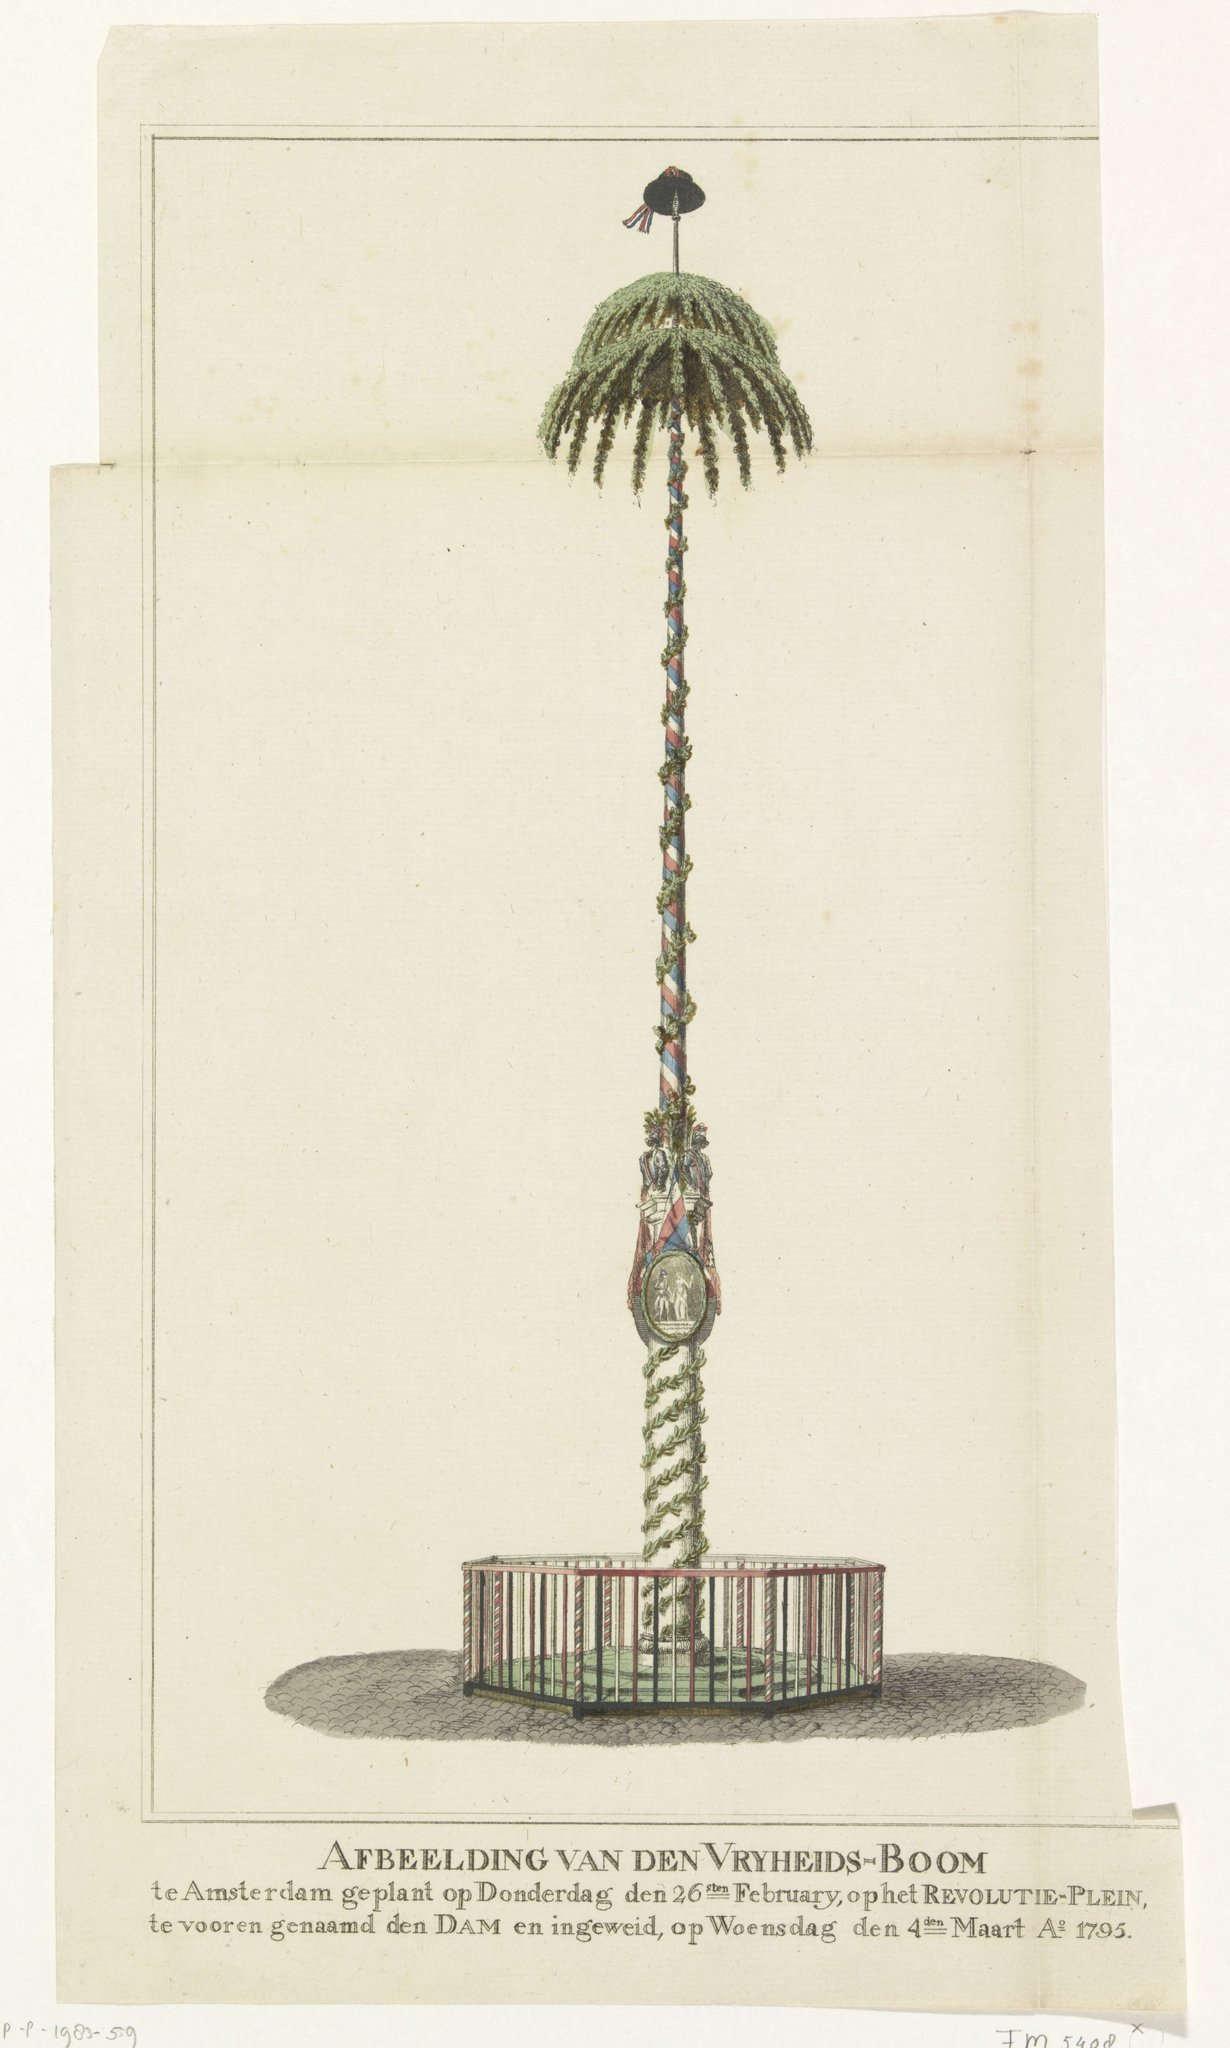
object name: print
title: Vijftien decoraties bij het Alliantiefeest te Amsterdam in 1795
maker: Anonymous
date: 1795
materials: paper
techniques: etching, hand coloring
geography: netherlands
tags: dancing around the tree of liberty, amsterdam, alliance with france (1795)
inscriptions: collector's mark: Lugt 2228, collector's mark: Lugt 2760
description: Deze prent is aangekocht en geïnventariseerd als behorend bij de serie van vijftien platen van de decoraties bij het Alliantiefeest te Amsterdam op 19 juni 1795, maar behoort niet waarschijnlijk niet tot deze groep.